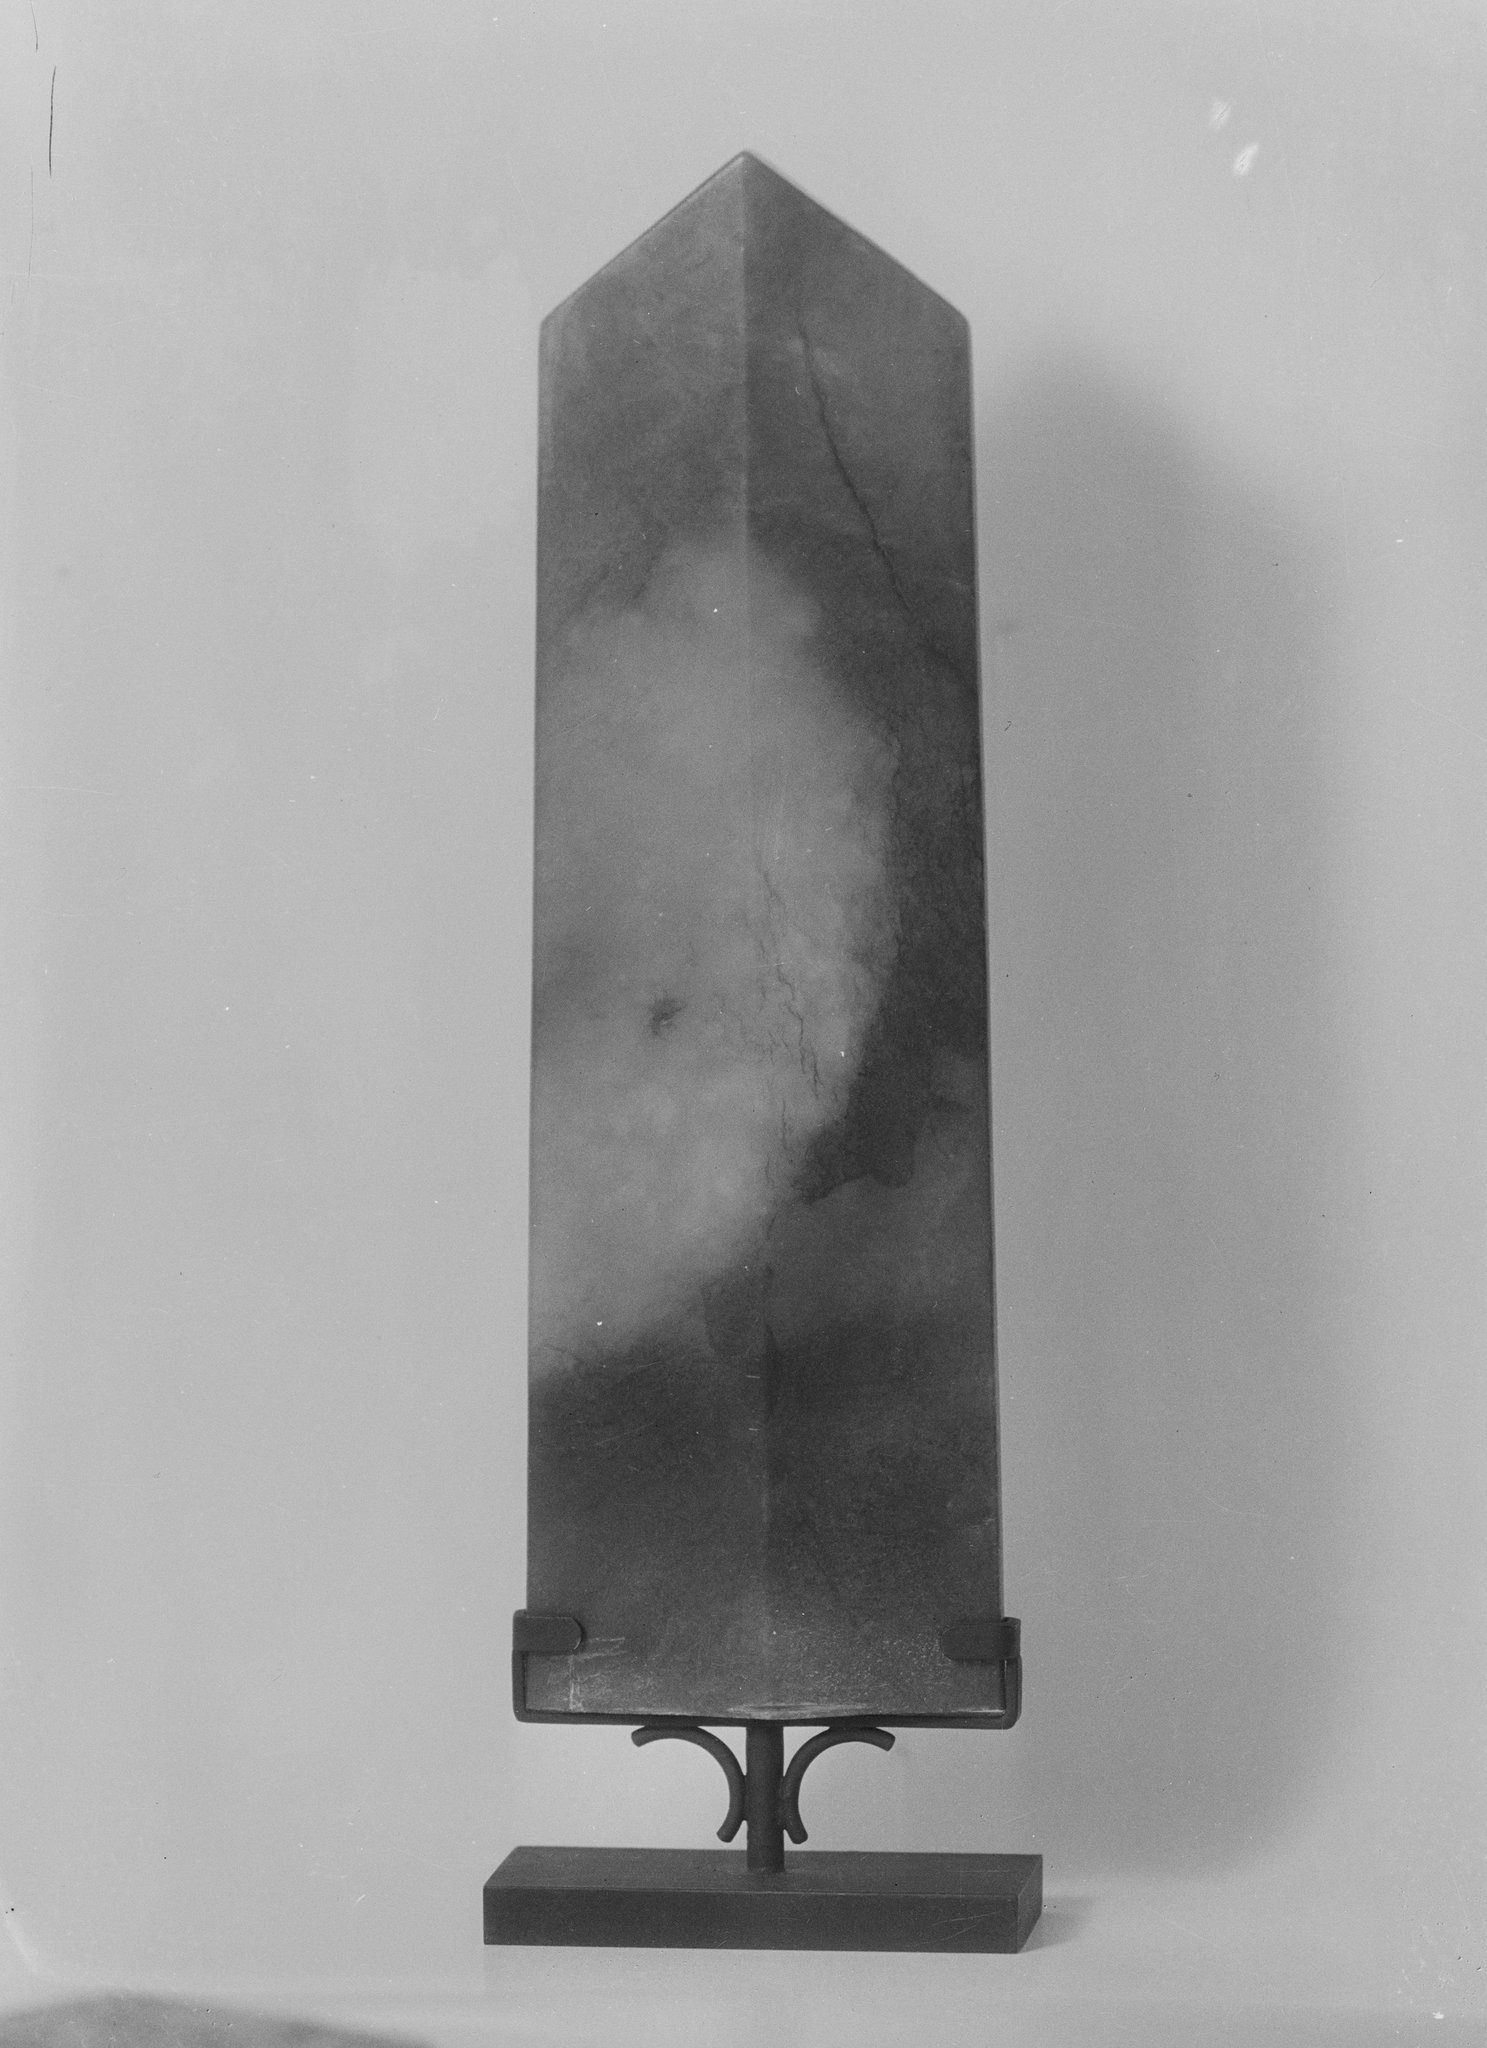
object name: tablet of rank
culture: chinese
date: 206 BCE-220 CE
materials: jade